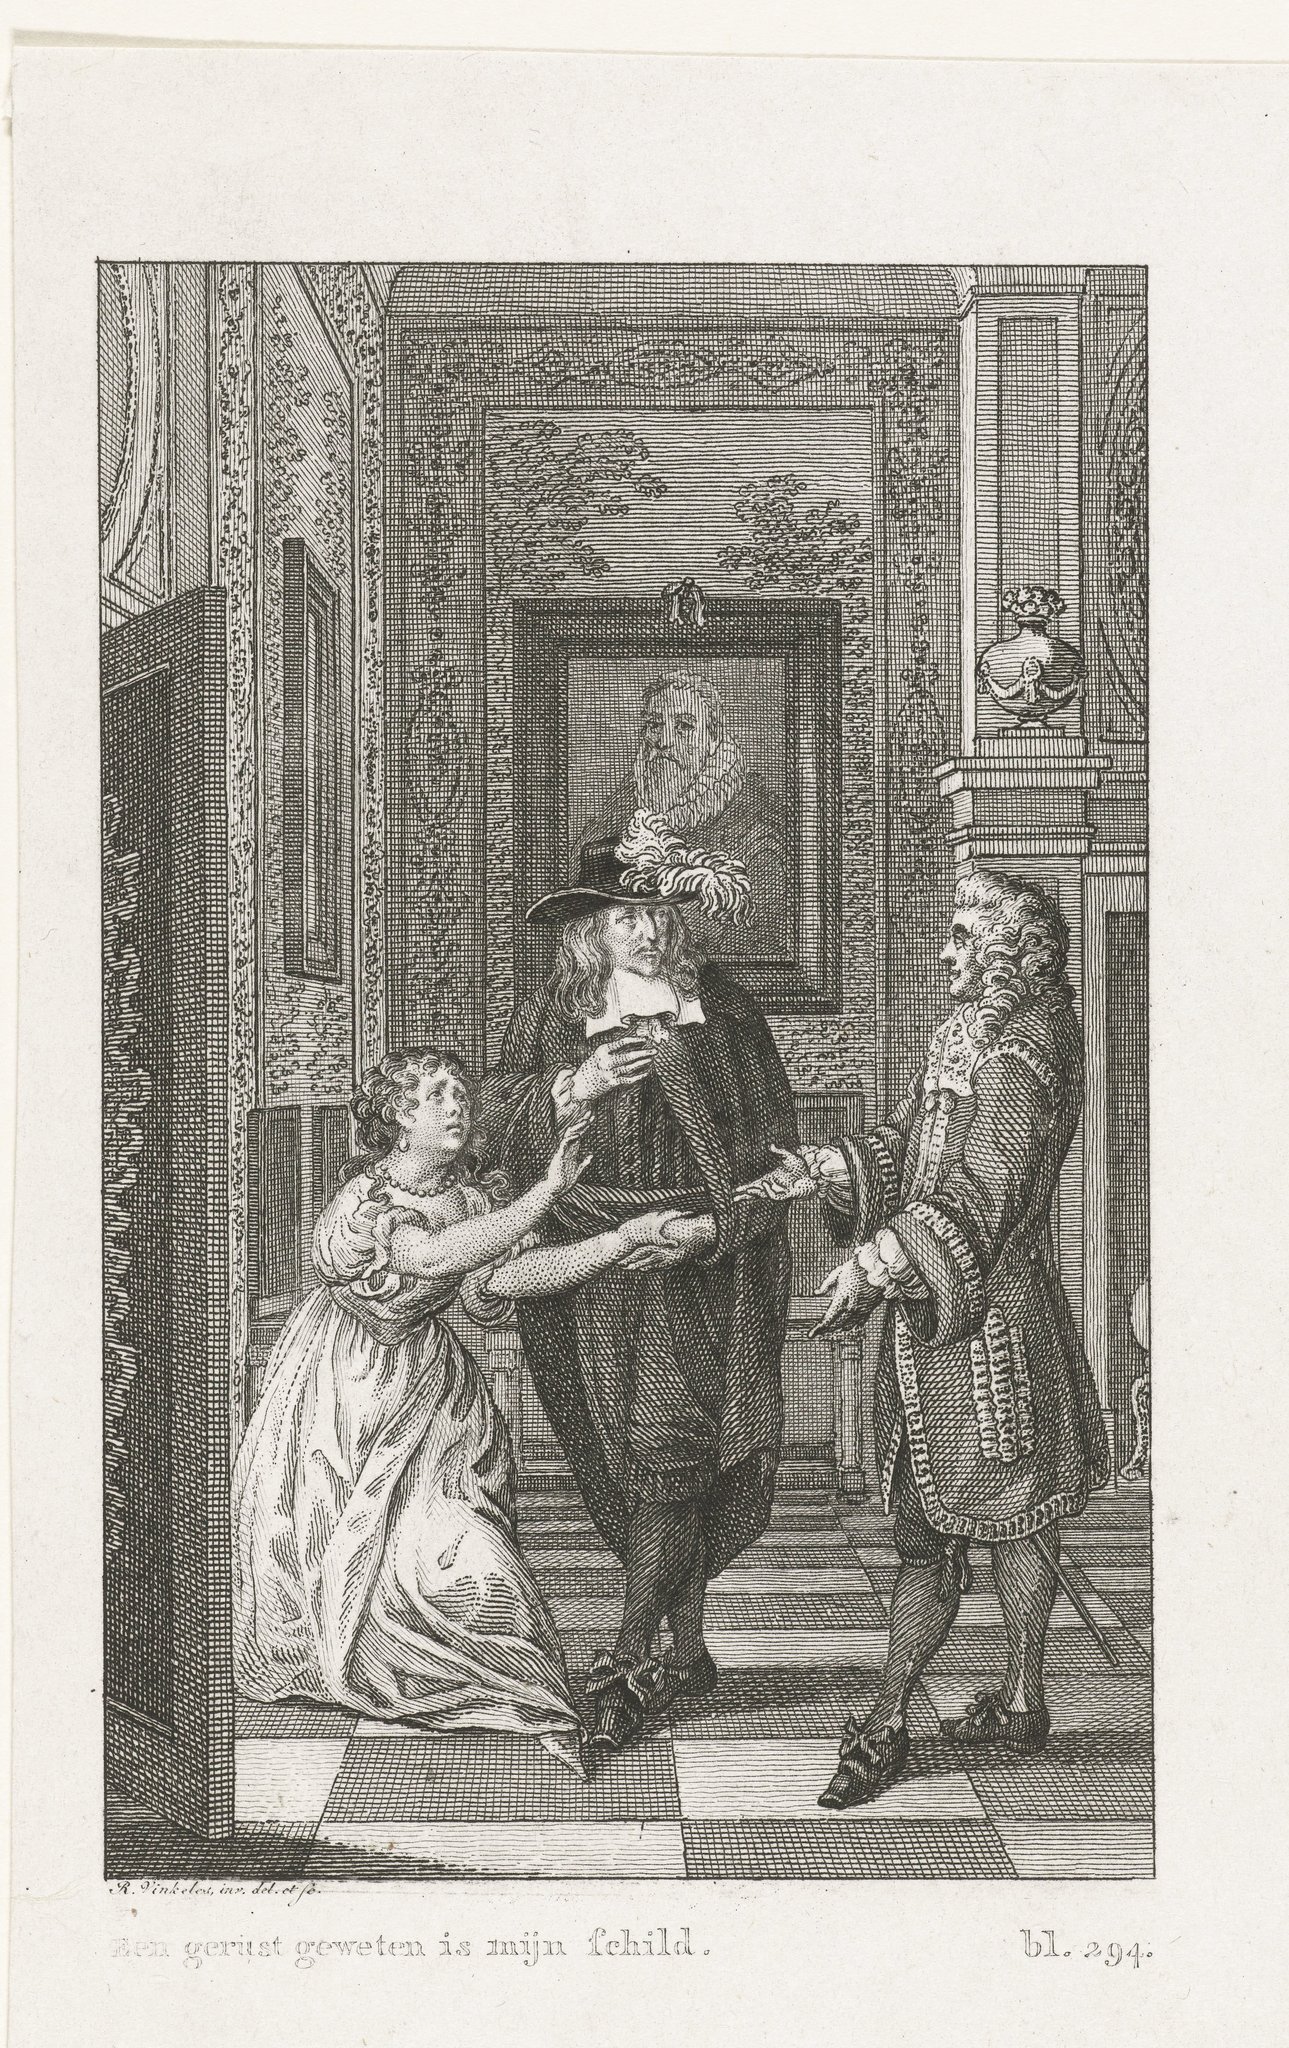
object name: print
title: Johan de Witt door zijn dochter gesmeekt zijn gevangengenomen broer niet te bezoeken, 1672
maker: reinier vinkeles (i)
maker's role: draughtsman, print maker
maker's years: 1741-1816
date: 1751-1816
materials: paper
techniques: etching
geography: northern netherlands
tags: dordrecht, cornelis de witt, politician, johan de witt, asking someone not to leave, the hague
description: Johan de Witt door zijn dochter gesmeekt zijn gevangengenomen broer Cornelis in de Gevangenpoort niet te gaan bezoeken, 20 augustus 1672. Met als onderschrift: Een gerust geweten is mijn schild. Rechtsonder gemerkt: bl. 294.